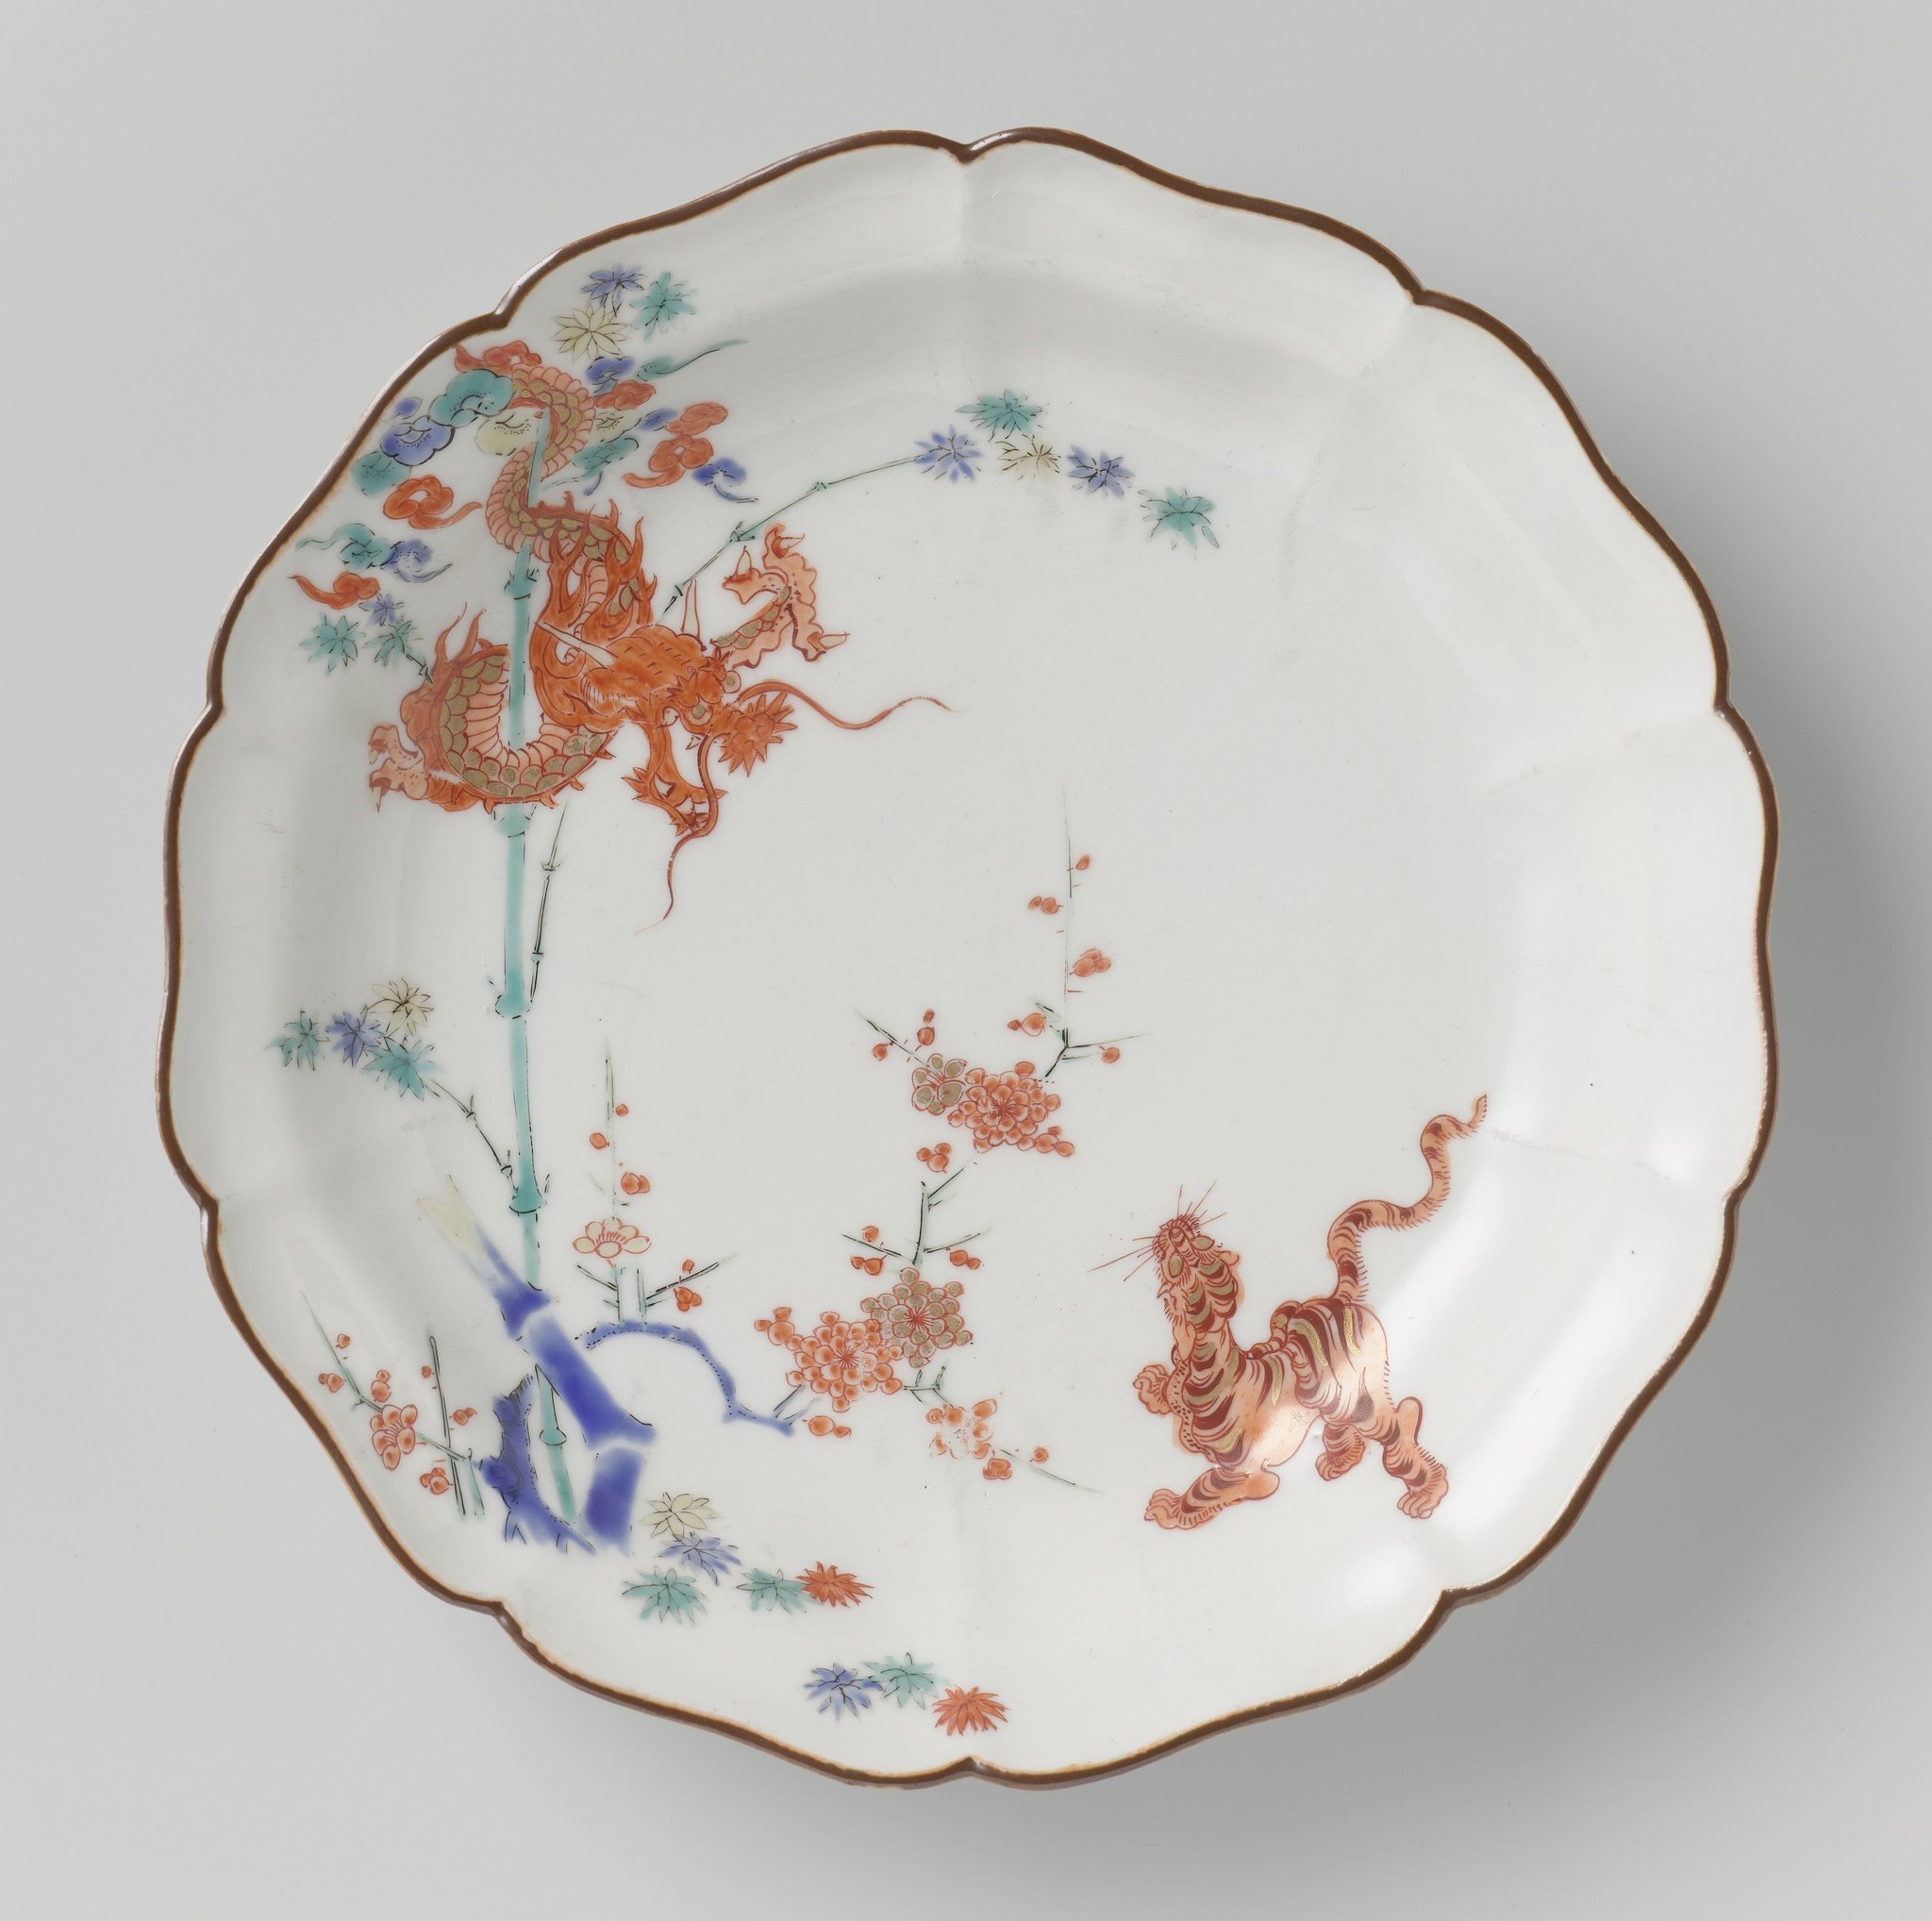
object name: plate dish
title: Lobed dish with dragon, tiger, bamboo and prunus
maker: Anonymous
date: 1670-1690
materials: glaze, gold, paint, porcelain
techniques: forming, gilding, turning, vitrification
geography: japan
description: Dish, c. 1690 - 1725.